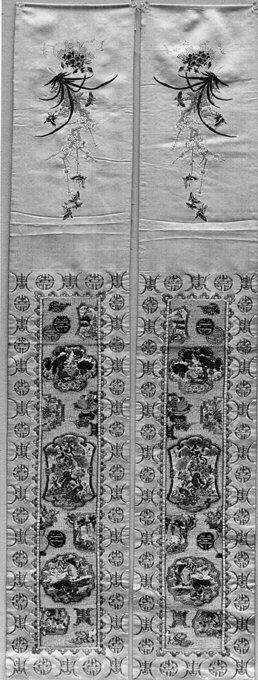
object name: sleeve band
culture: chinese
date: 1801-1900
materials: metal thread, silk